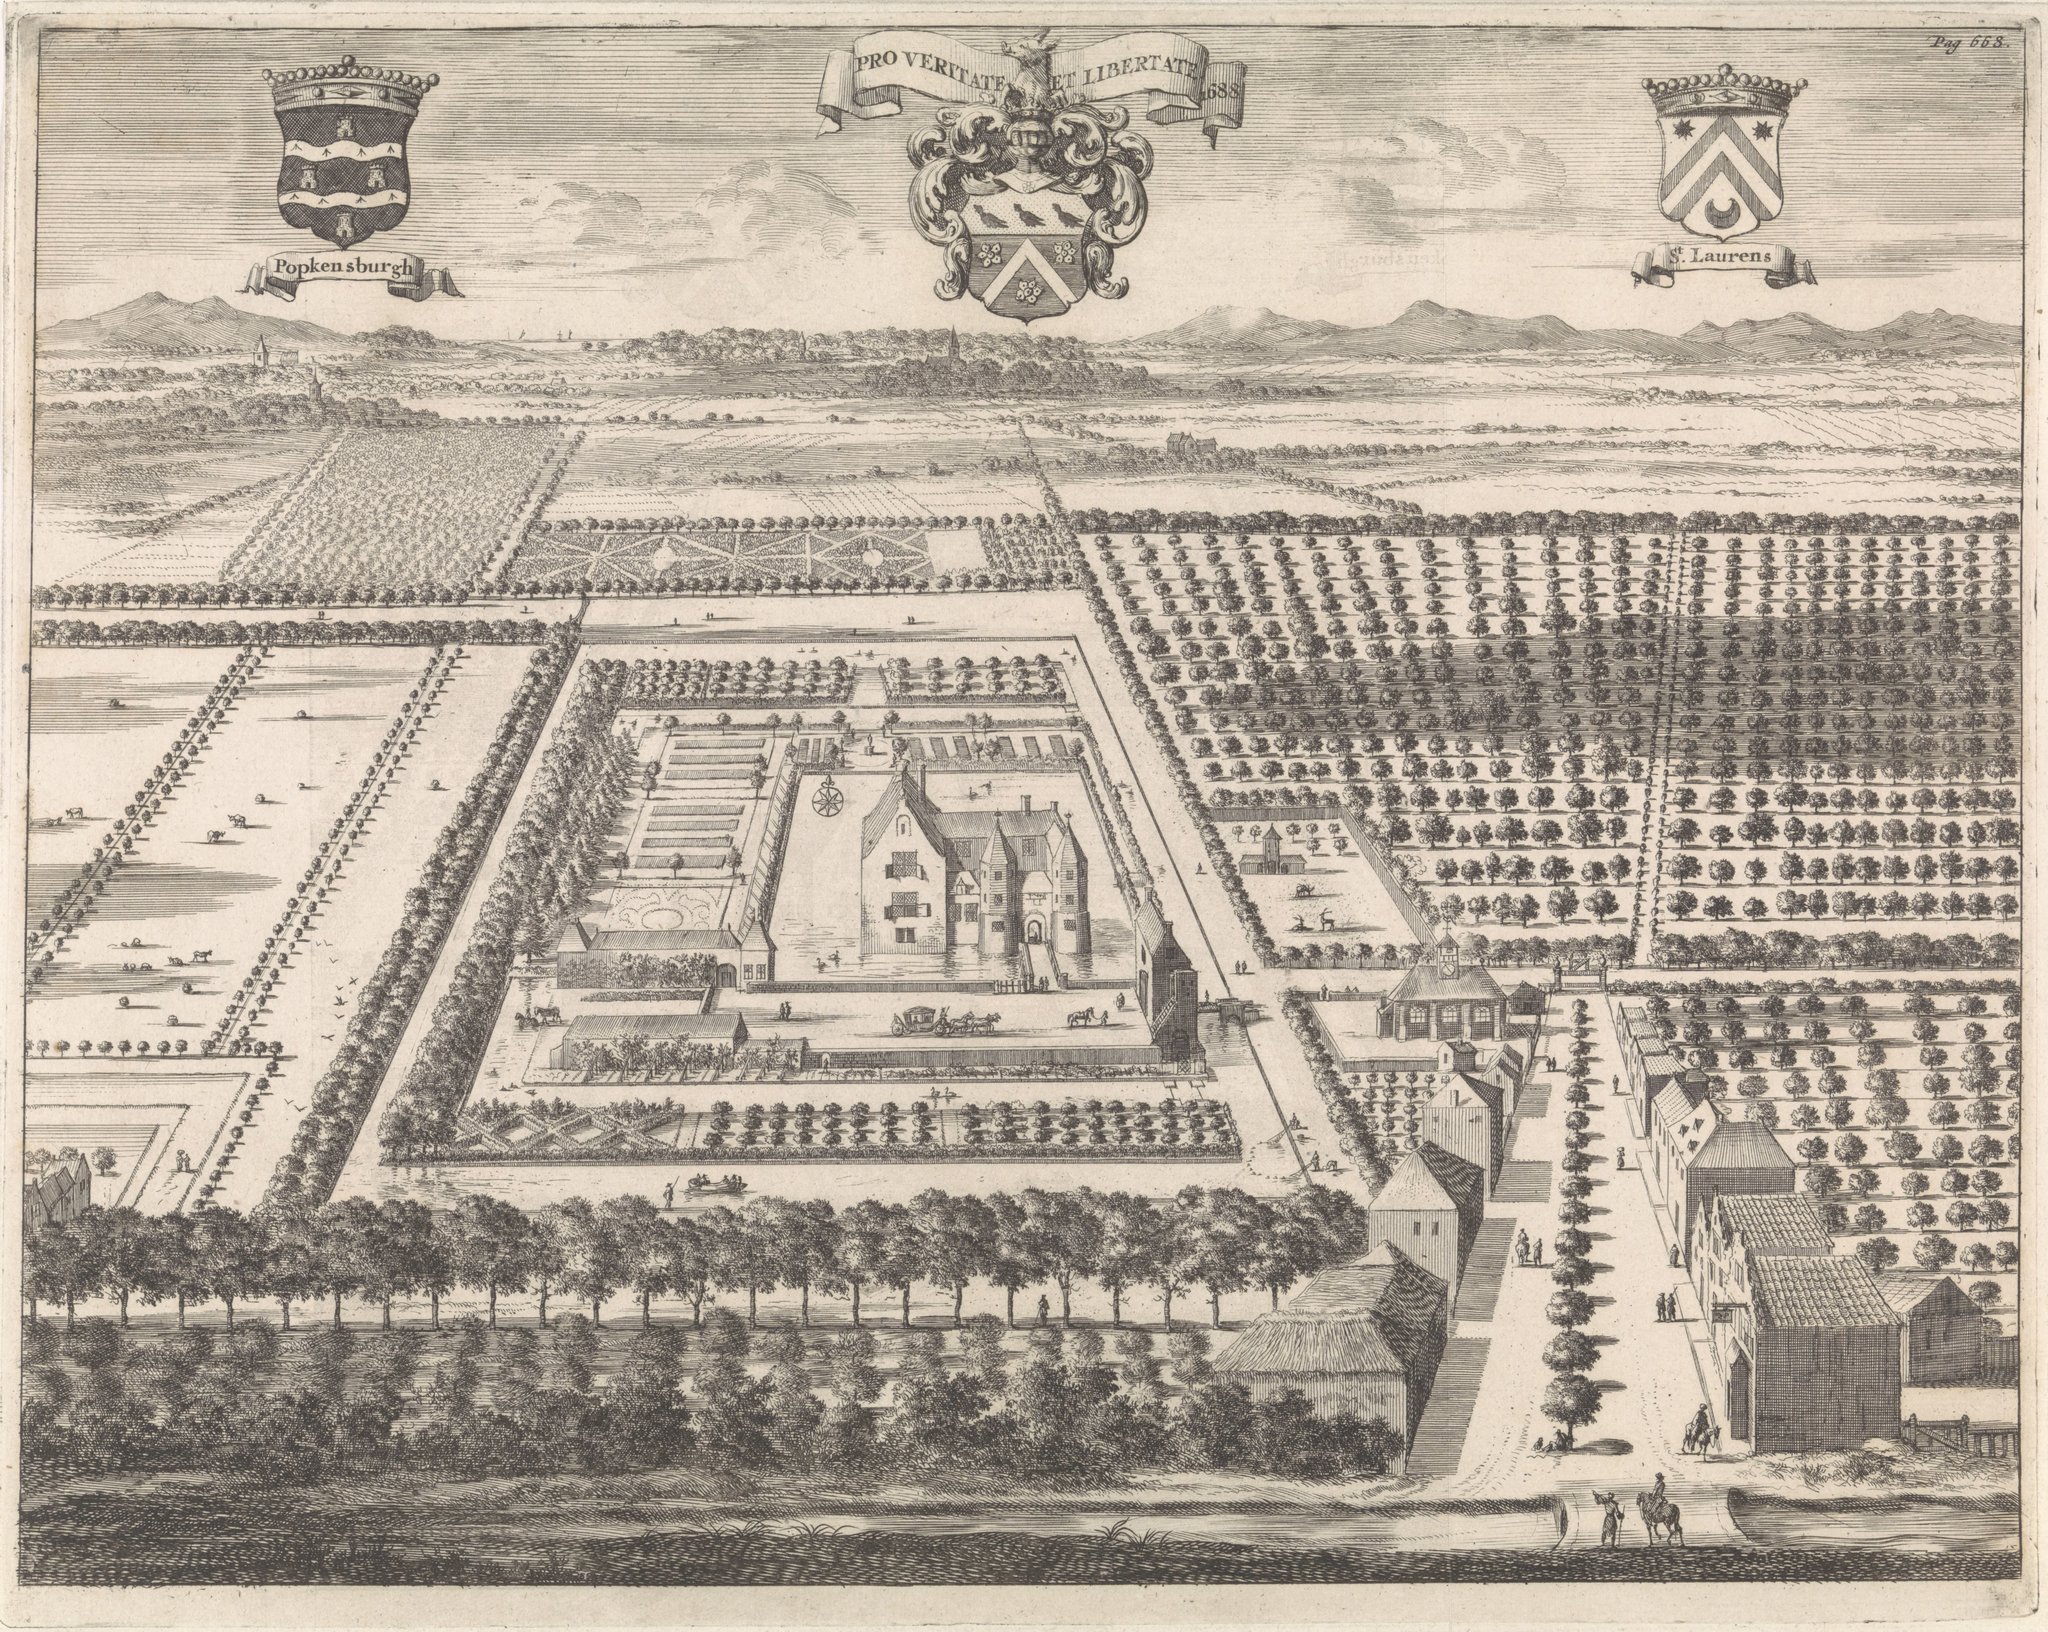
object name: print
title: Gezicht op Kasteel Popkensburg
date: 1696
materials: paper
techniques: engraving, etching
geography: amsterdam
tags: prospect of village, silhouette of village, coat of arms (as symbol of the state, etc.) (+ city; municipal), castle, french or architectonic garden; formal garden, orchard, armorial bearing, heraldry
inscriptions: collector's mark: Lugt 2228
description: Gezicht op Kasteel Popkensburg te Sint Laurens op Walcheren, in vogelvluchtperspectief. In het midden het kasteel, daaromheen de tuinen en boomgaarden. Linksboven het wapen van Popkensburg, in het midden het wapen van eigenaar Johan Boudaen Courten, rechtsboven het wapen van Sint Laurens. Rechtsboven gemerkt: Pag. 668.